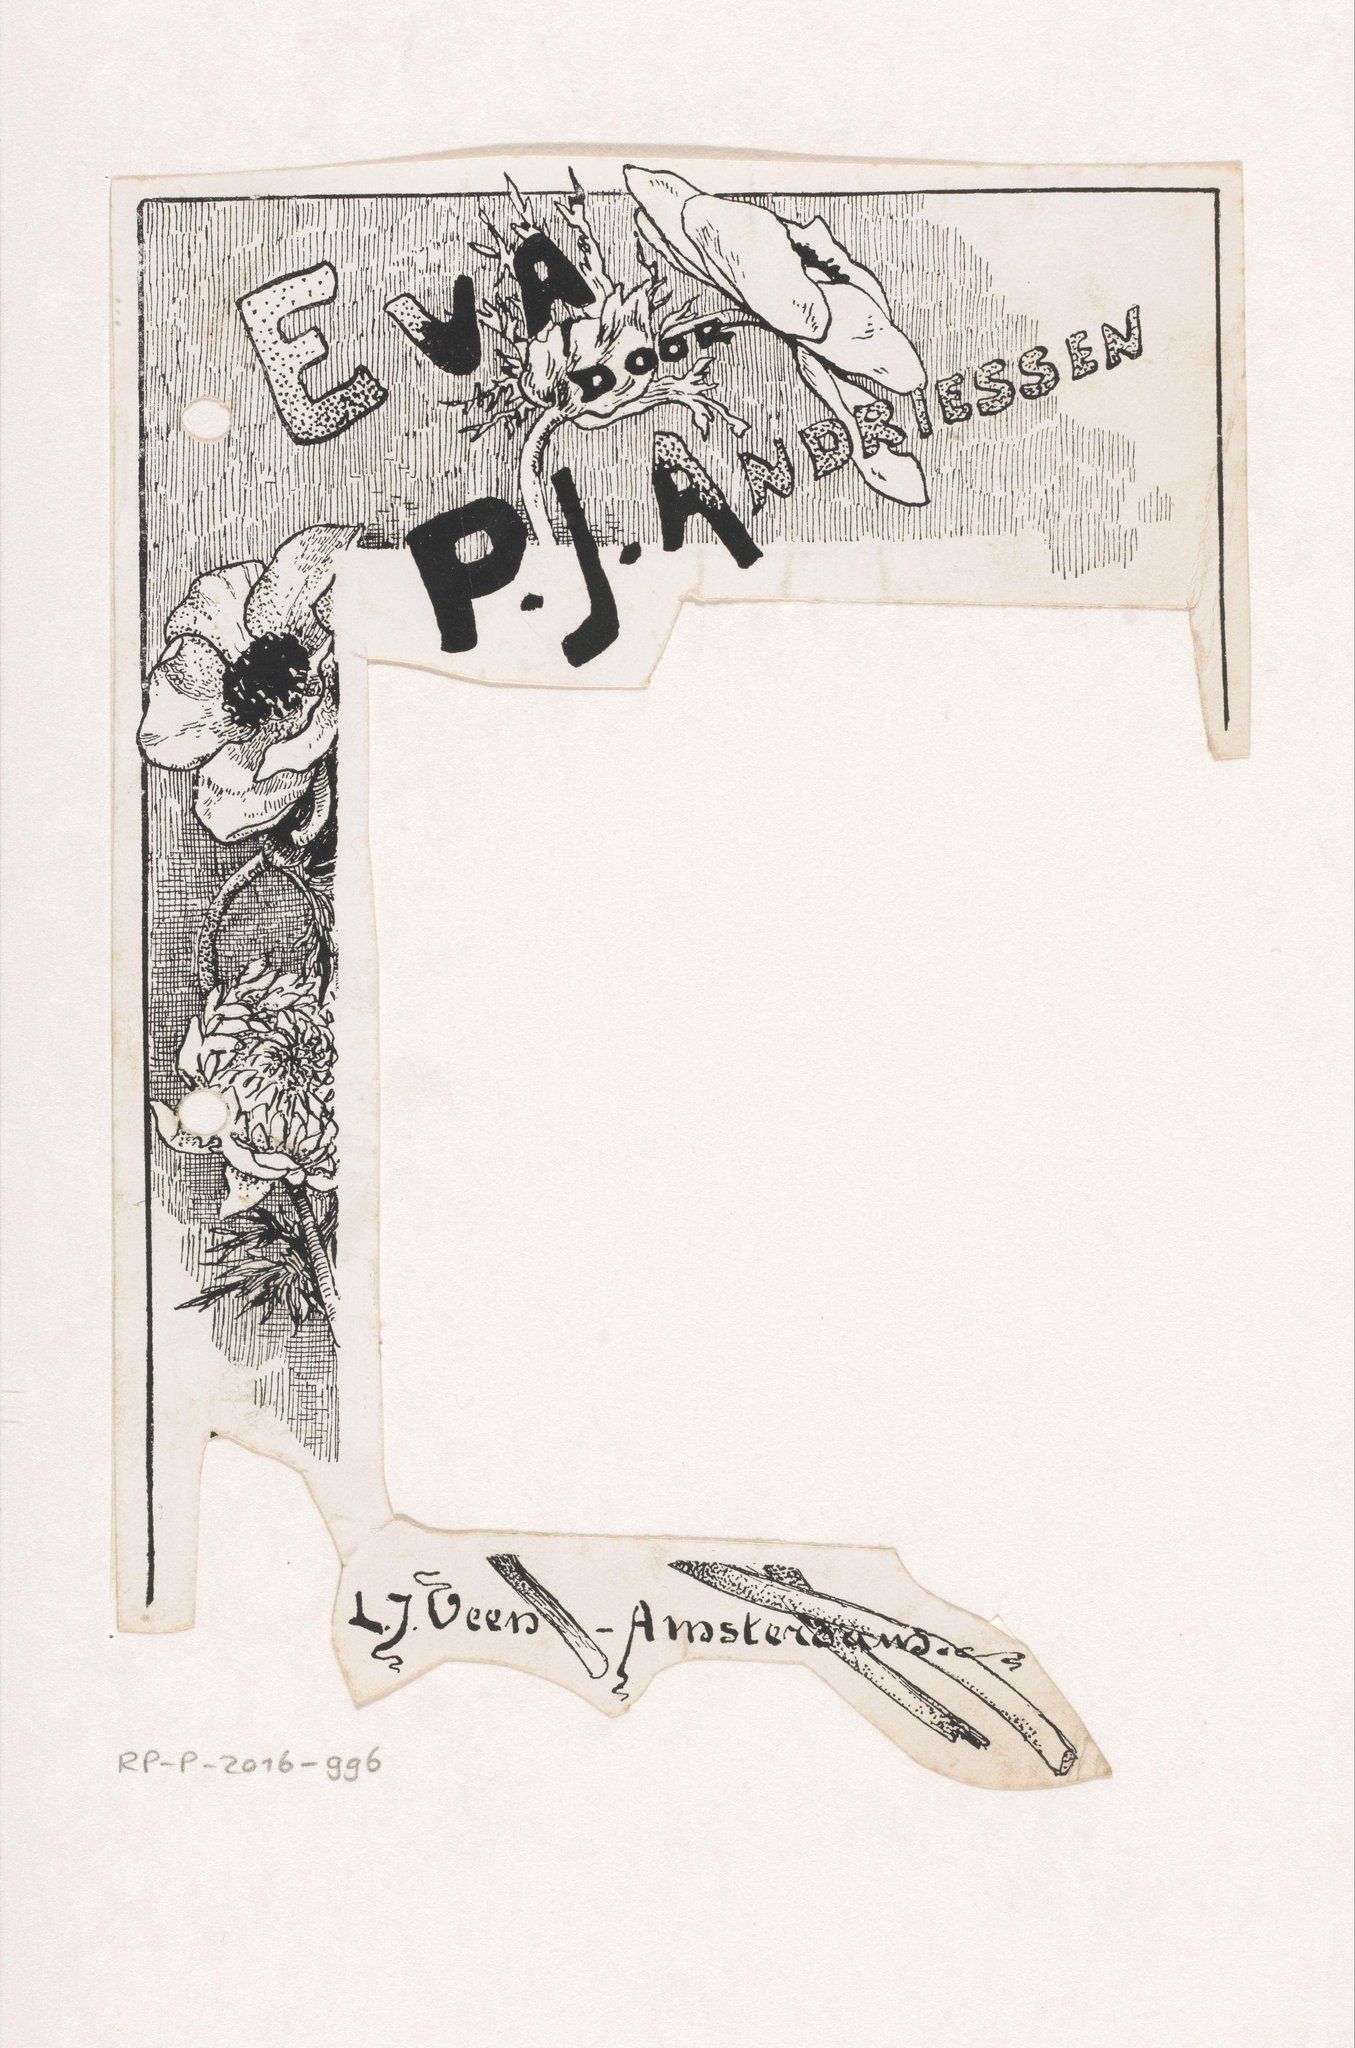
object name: study for binding design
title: Bandontwerp voor: P.J. Andriessen, Eva, 1893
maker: Anonymous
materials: paper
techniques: printing block, snipping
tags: flowers ~ ornament